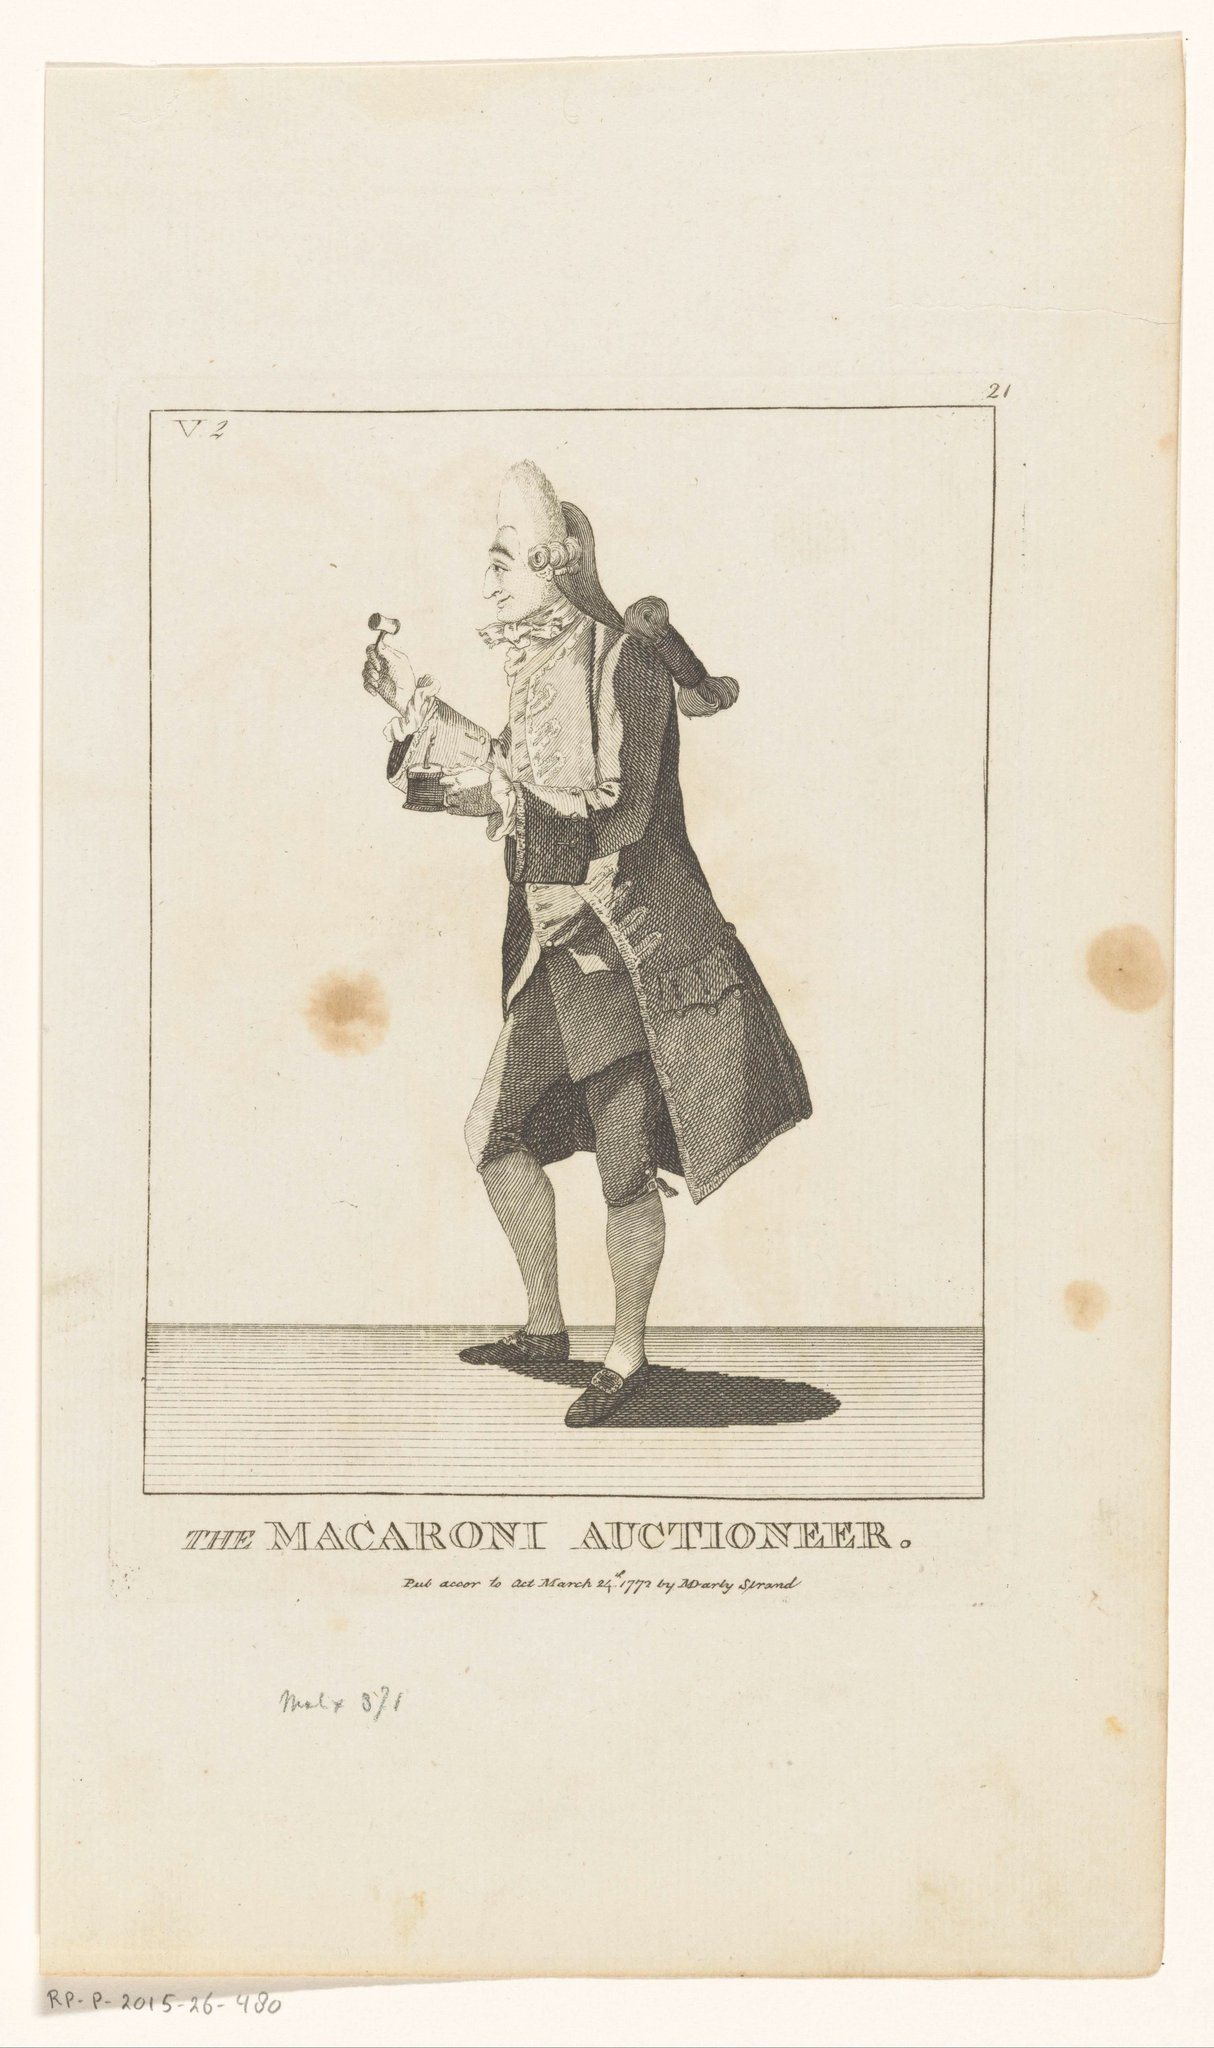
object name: print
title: Macaroni veilingmeester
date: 1703-1772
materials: paper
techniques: etching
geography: london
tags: london, auctioneer, caricatures (human types), art sale, auction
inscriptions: collector's mark: Lugt 4779, collector's mark: Lugt 4780, collector's mark: Lugt 2228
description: Afkomstig uit de tweede serie van zes, getiteld: Macaronies, Characters, Caricatures &cd, uitgegeven door Matthew Darly in Londen tussen 1771 en 1773. De term 'macaronie' werd gebruikt in Engeland in de tweede helft van de 18de eeuw voor personen die op een overdreven wijze de laatste mode volgden. In zekere zin vormden zij de voorlopers van de dandy's. Deze Macaroni stelt waarschijnlijk de toneelschrijver en veilinghouder Abraham Langford (1711-1774) voor.